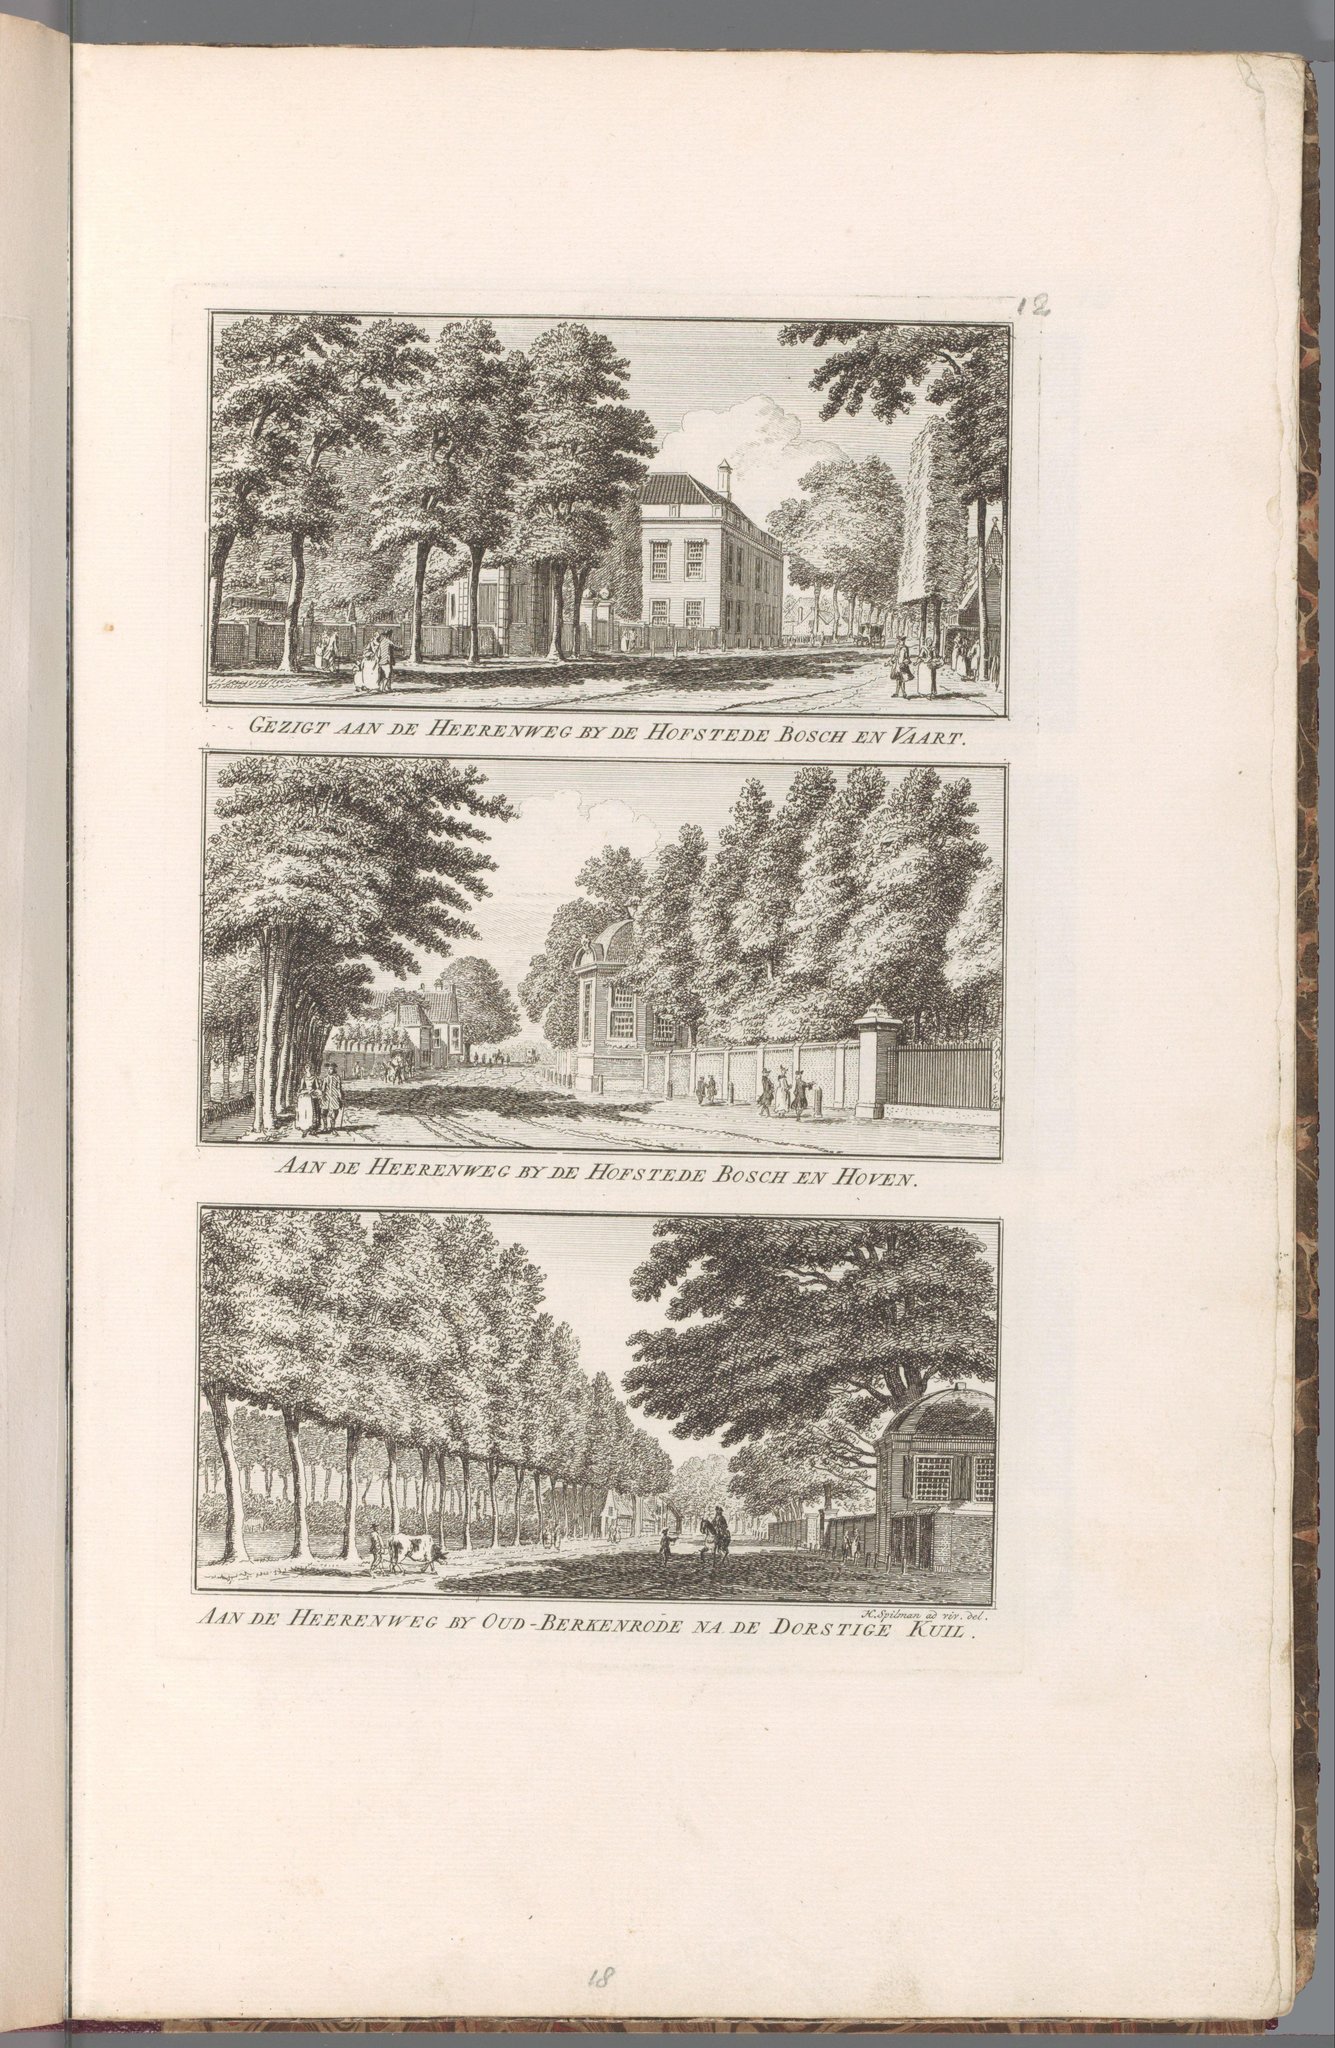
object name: album leaf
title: Gezigt aan de Heerenweg by de Hofstede Bosch en Vaart / Aan de Heerenweg by de Hofstede Bosch en Hoven / Aan de Heerenweg by Oud-Berkenrode na de Dorstige Kuil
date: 1762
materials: paper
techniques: etching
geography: haarlem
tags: rural housing, e.g. country-house, villa, cottage, lane, alley, haarlem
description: Drie voorstellingen. Boven: De Herenweg te Haarlem bij de hofstede Bosch en Vaart. Midden: De Herenweg te Haarlem bij de hofstede Bosch en Hoven. Onder: De Herenweg (in het huidige Heemstede) bij de hofstede Oud Berkenrode. Deze prent maakt deel uit van een album.